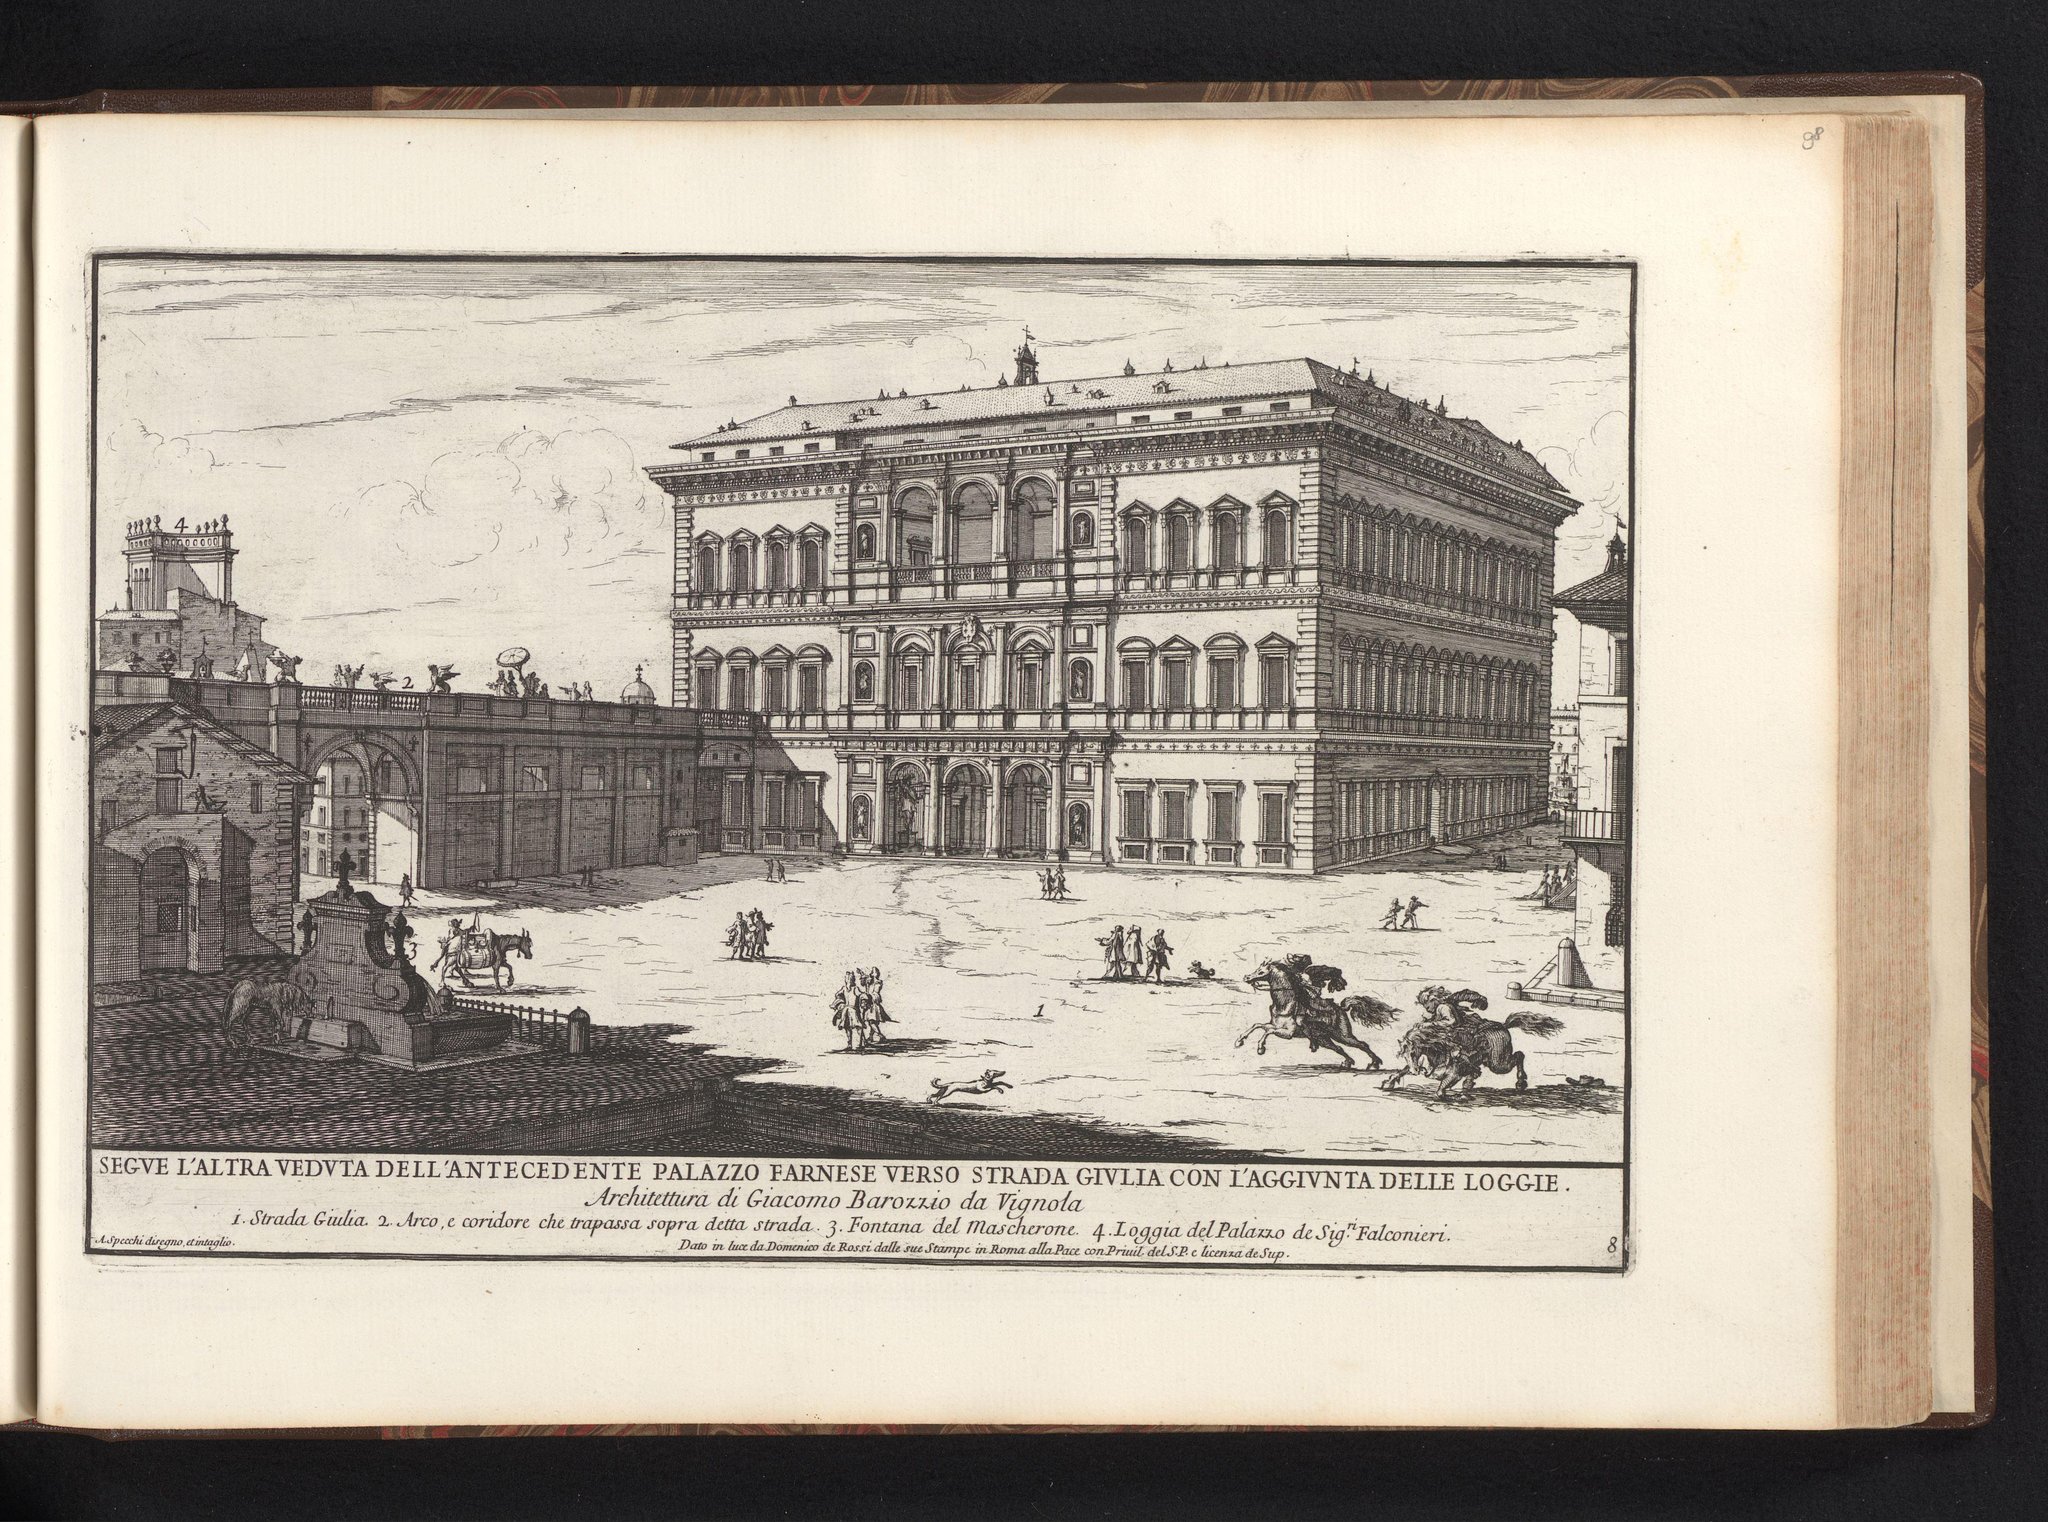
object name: album leaf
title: Moderne gebouwen te Rome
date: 1699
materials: paper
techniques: etching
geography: rome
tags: palace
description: Deze prent maakt deel uit van een reeks van 52 prenten met voorstellingen van paleizen in Rome. Samen met vier andere reeksen vormt het de grote reeks: 'Il nuovo teatro di Roma moderna'.